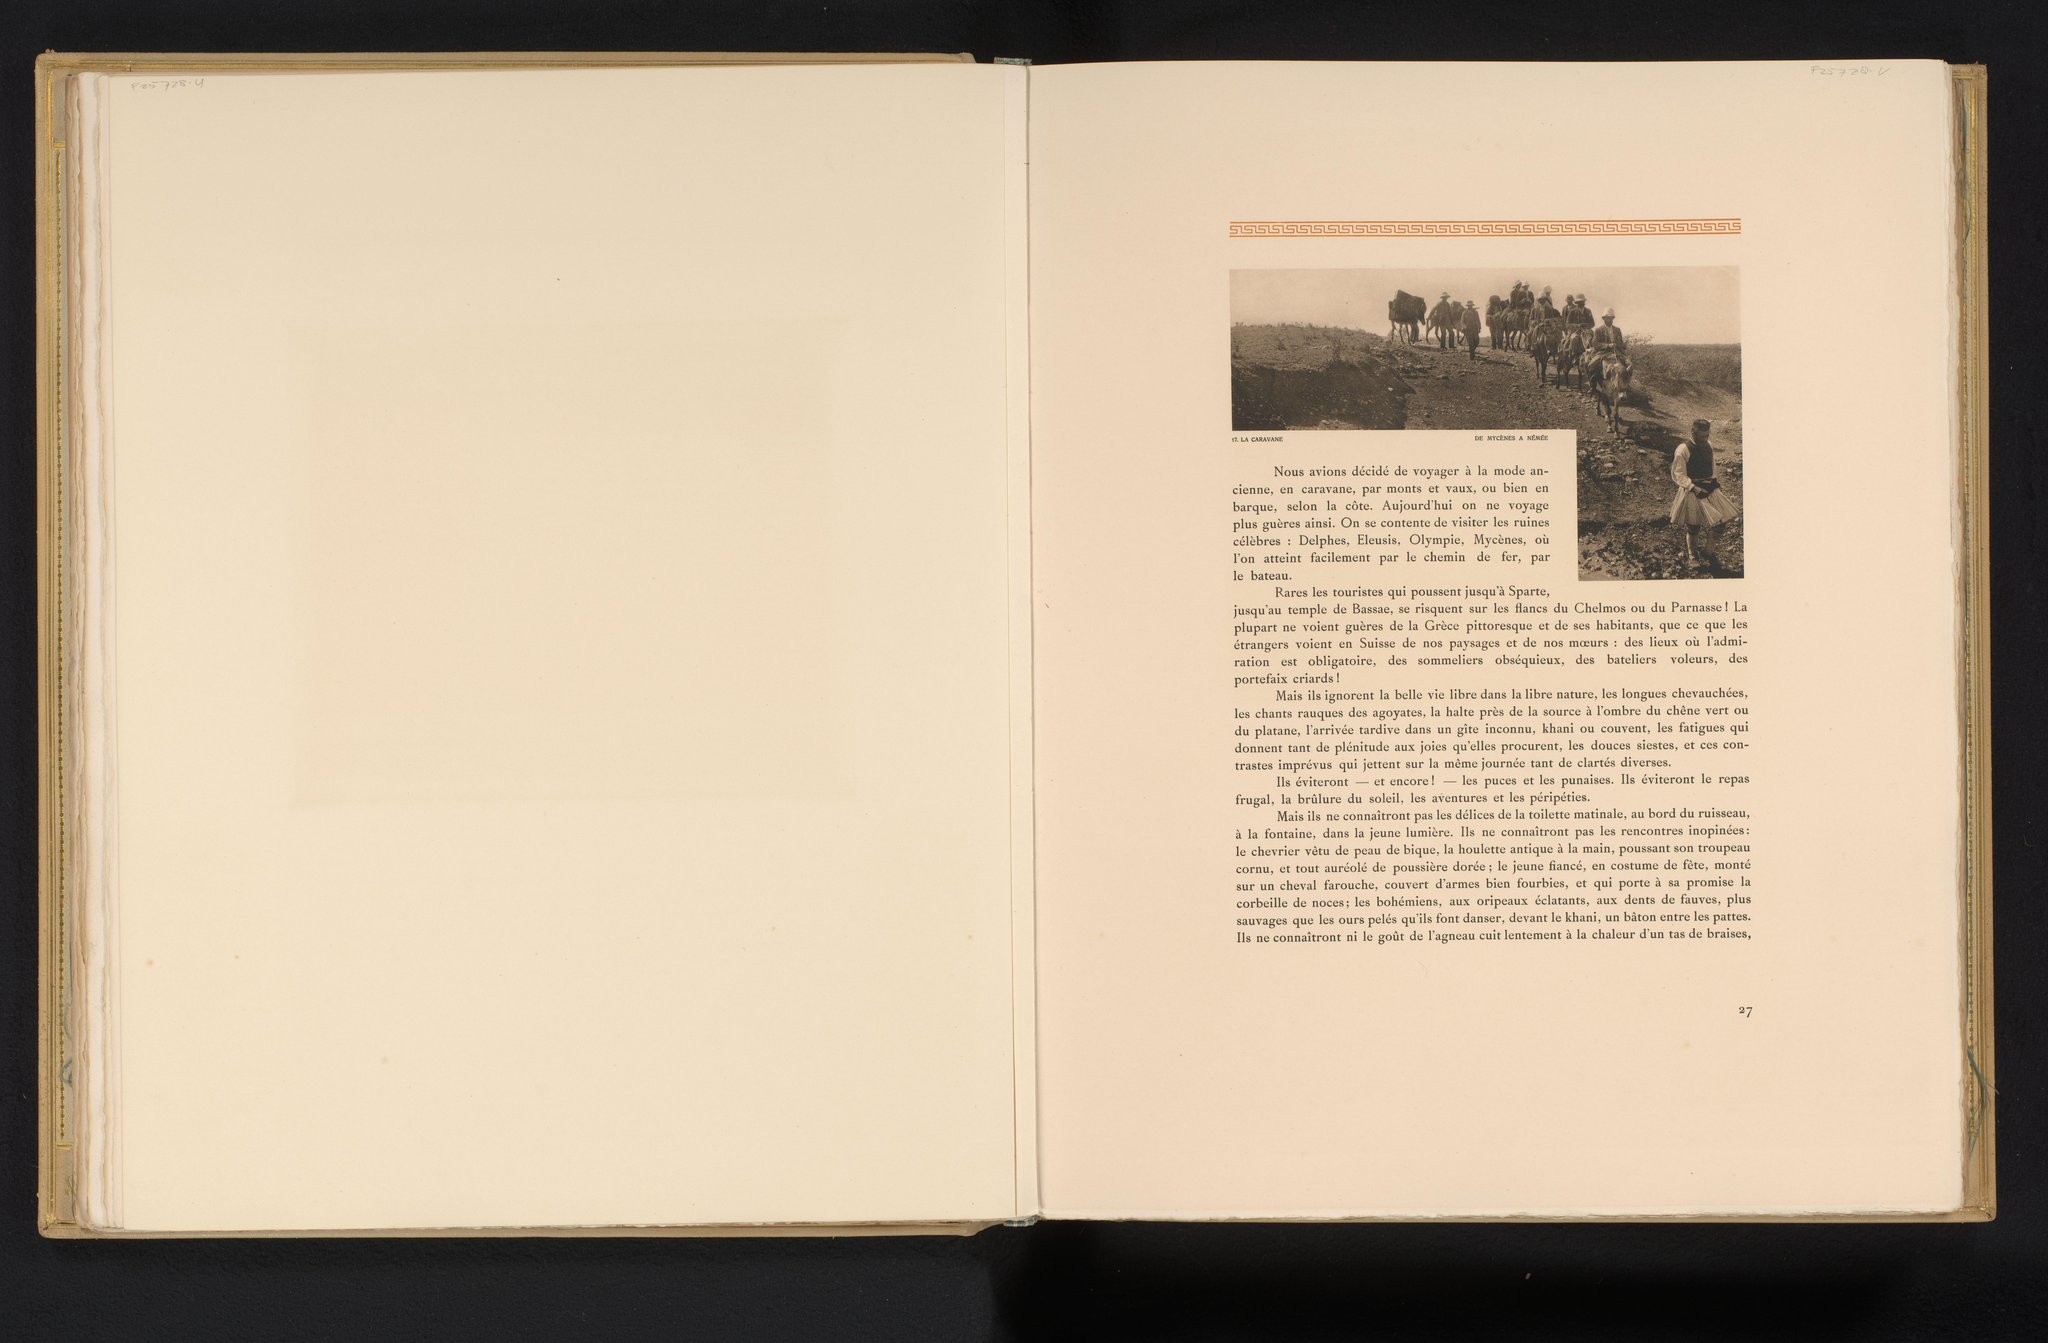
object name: photomechanical print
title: Karavaan onderweg van Mycene naar Nemea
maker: frédéric boissonnas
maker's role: fotograaf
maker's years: 1858-1946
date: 1905-1910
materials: paper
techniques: photograph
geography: berlin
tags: 'en route', traveller under way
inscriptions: number: ‘17.’